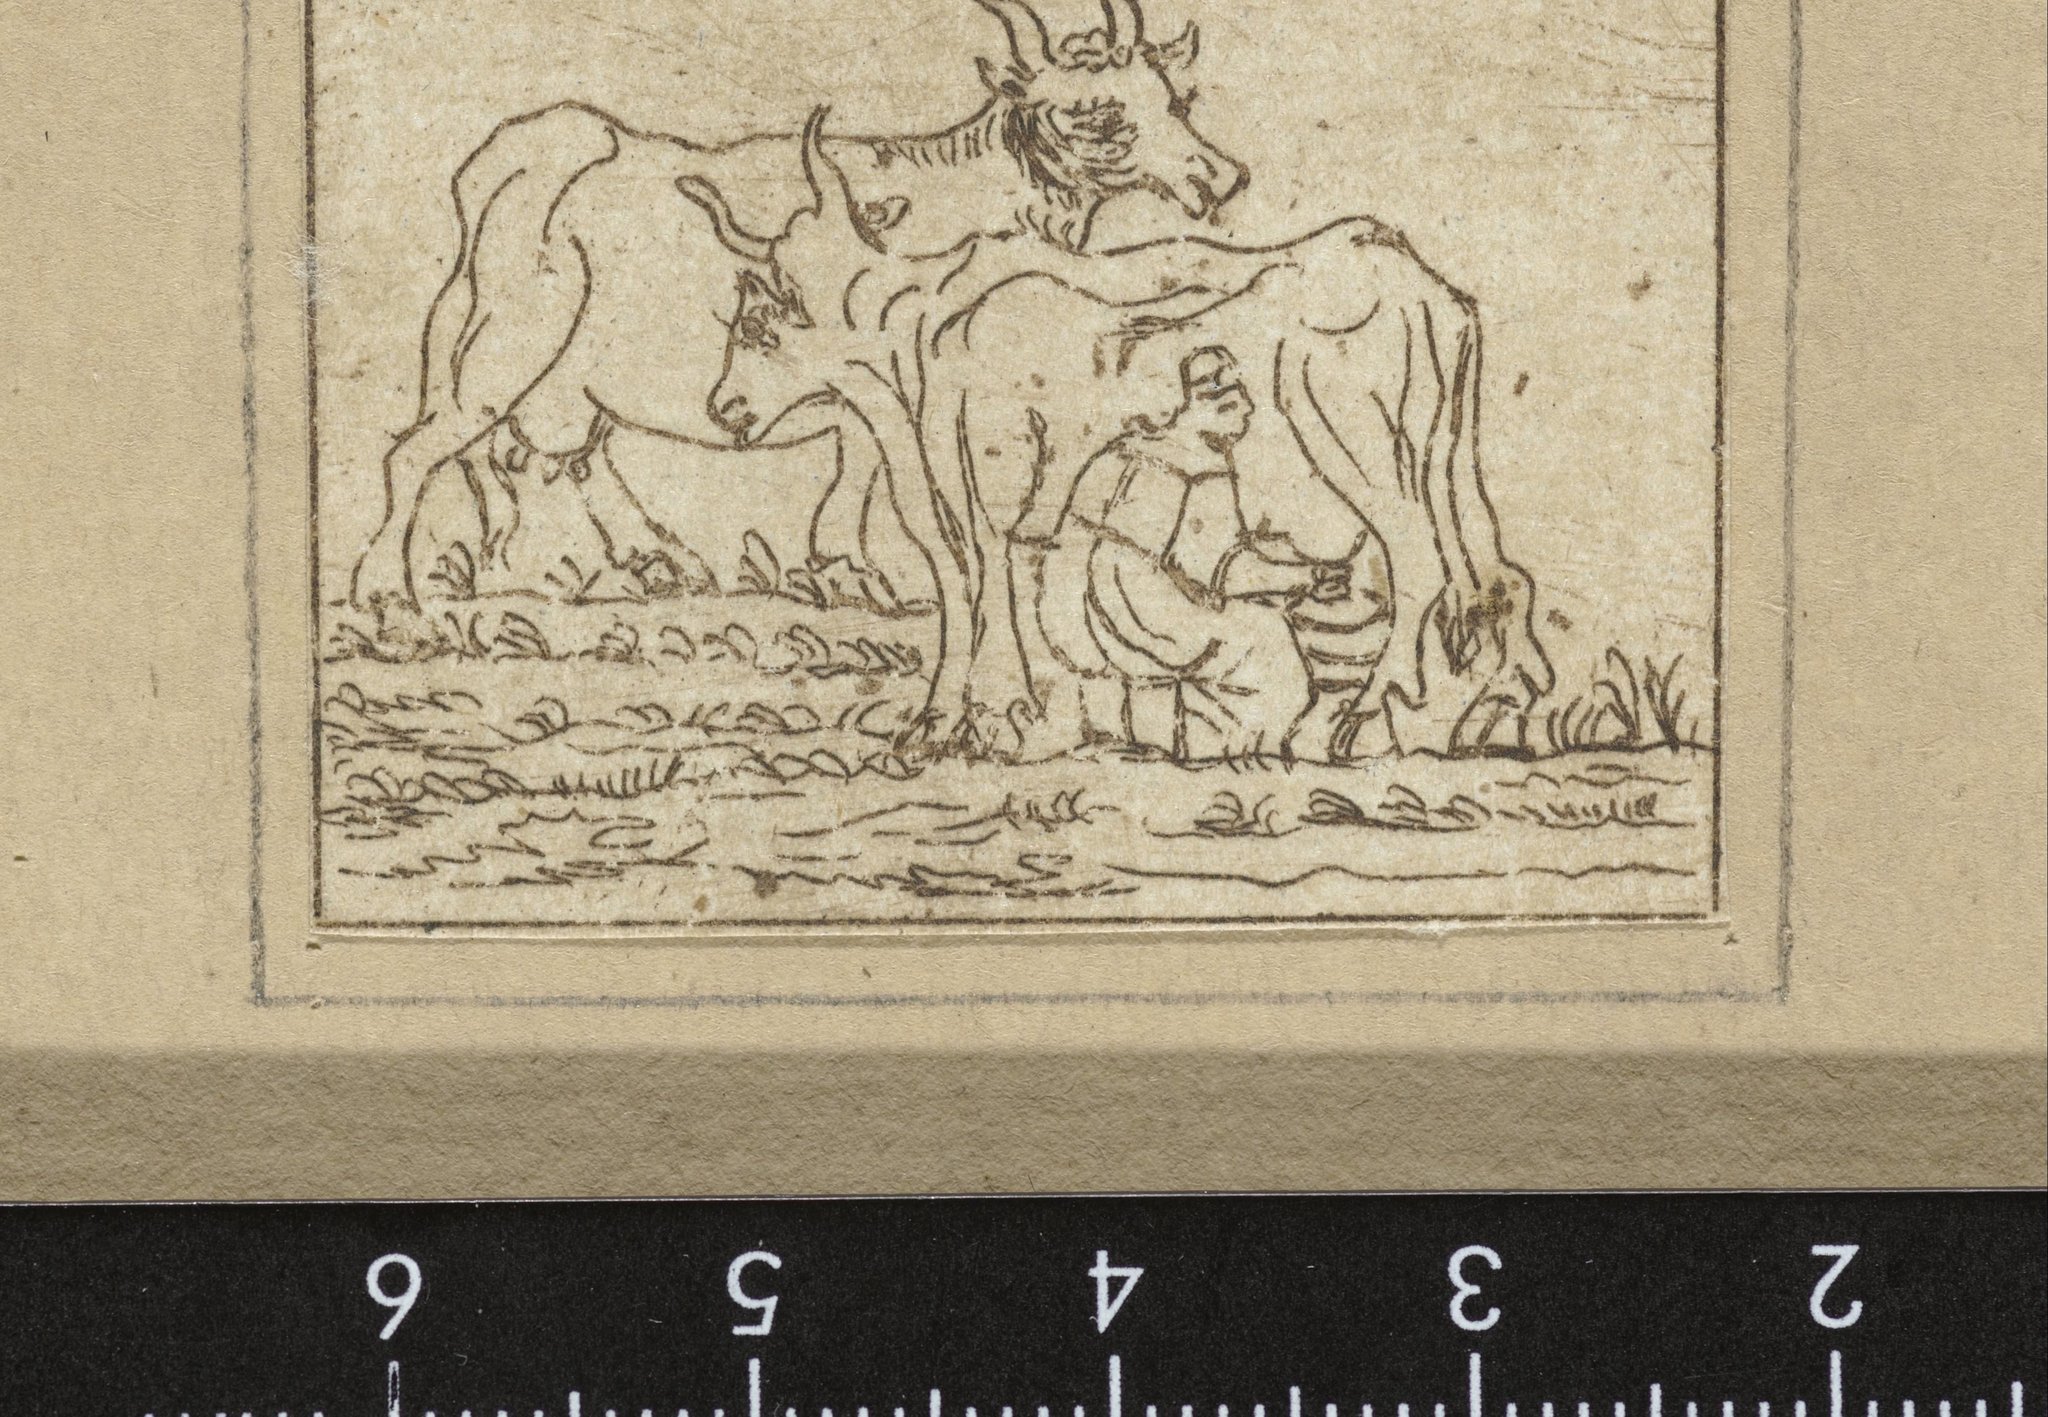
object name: print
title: Melkende boerin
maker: jacob hoolaart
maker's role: print maker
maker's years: 1713-1789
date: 1728-1789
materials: paper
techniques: etching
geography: dordrecht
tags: milking